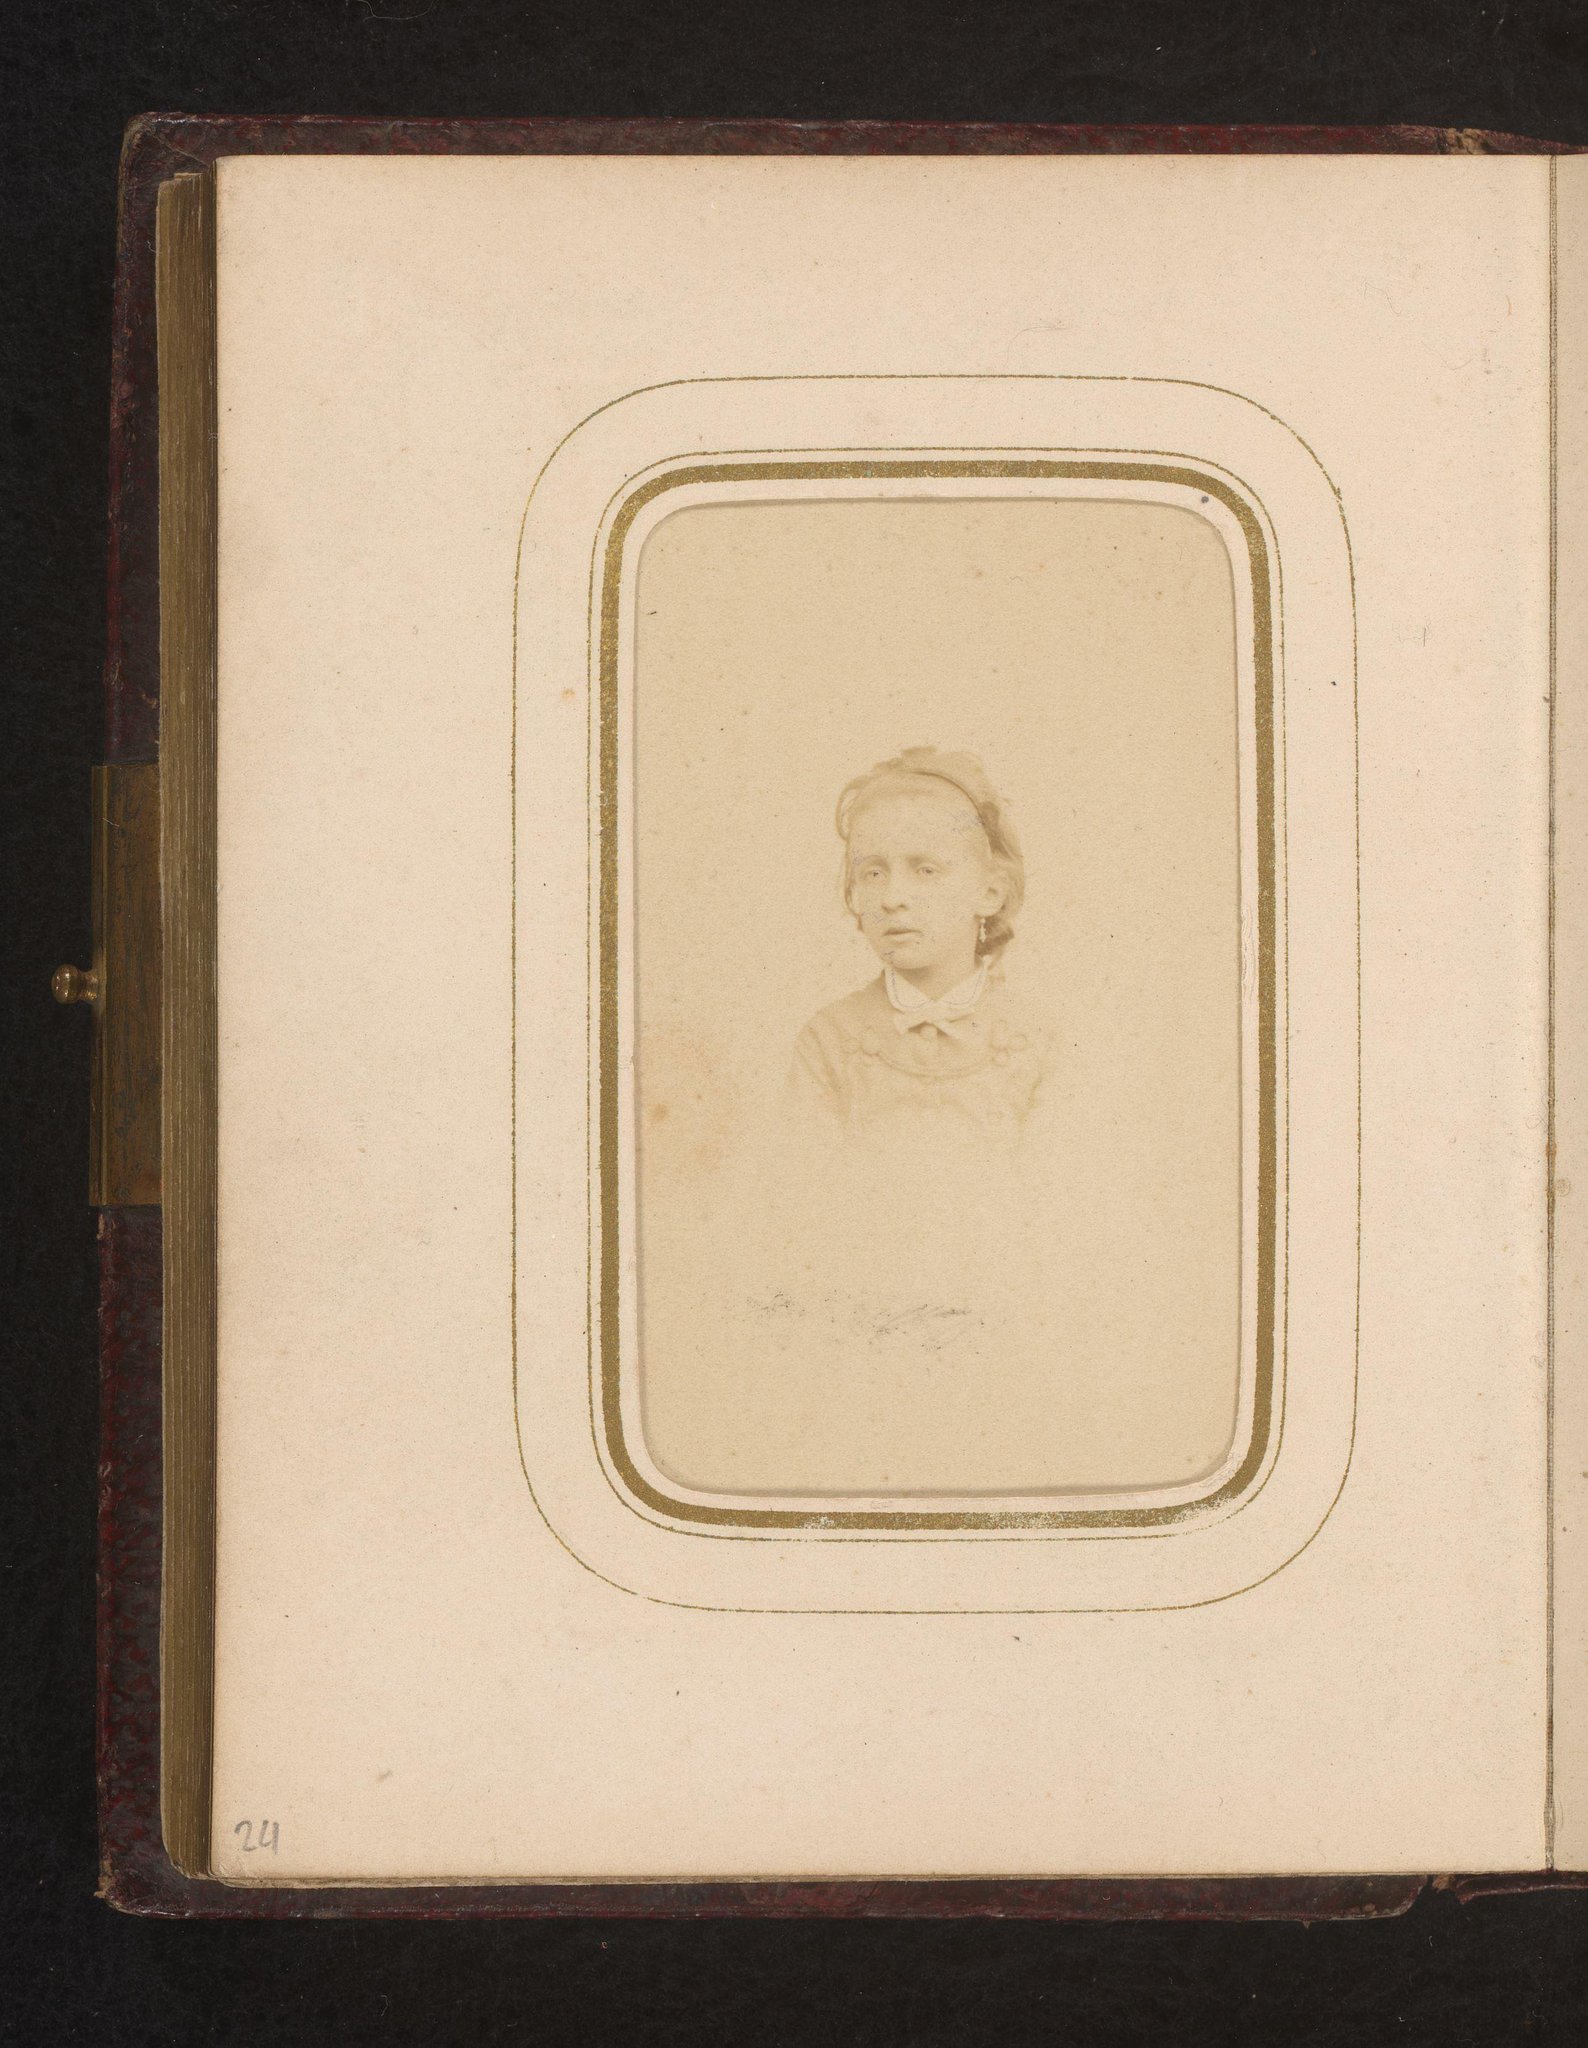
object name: photograph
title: Portret van een meisje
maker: constant peigné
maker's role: fotograaf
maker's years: 1834-1916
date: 1860-1890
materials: cardboard, photographic support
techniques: albumen print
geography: nantes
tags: girl (child between toddler and youth)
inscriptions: inscription: ‘Photographie/ Constant Peigné/ breveté s.g.d.g/ Rue Crébillon, 8/ 40, Rue Contrescarpe, 40/ Nantes’